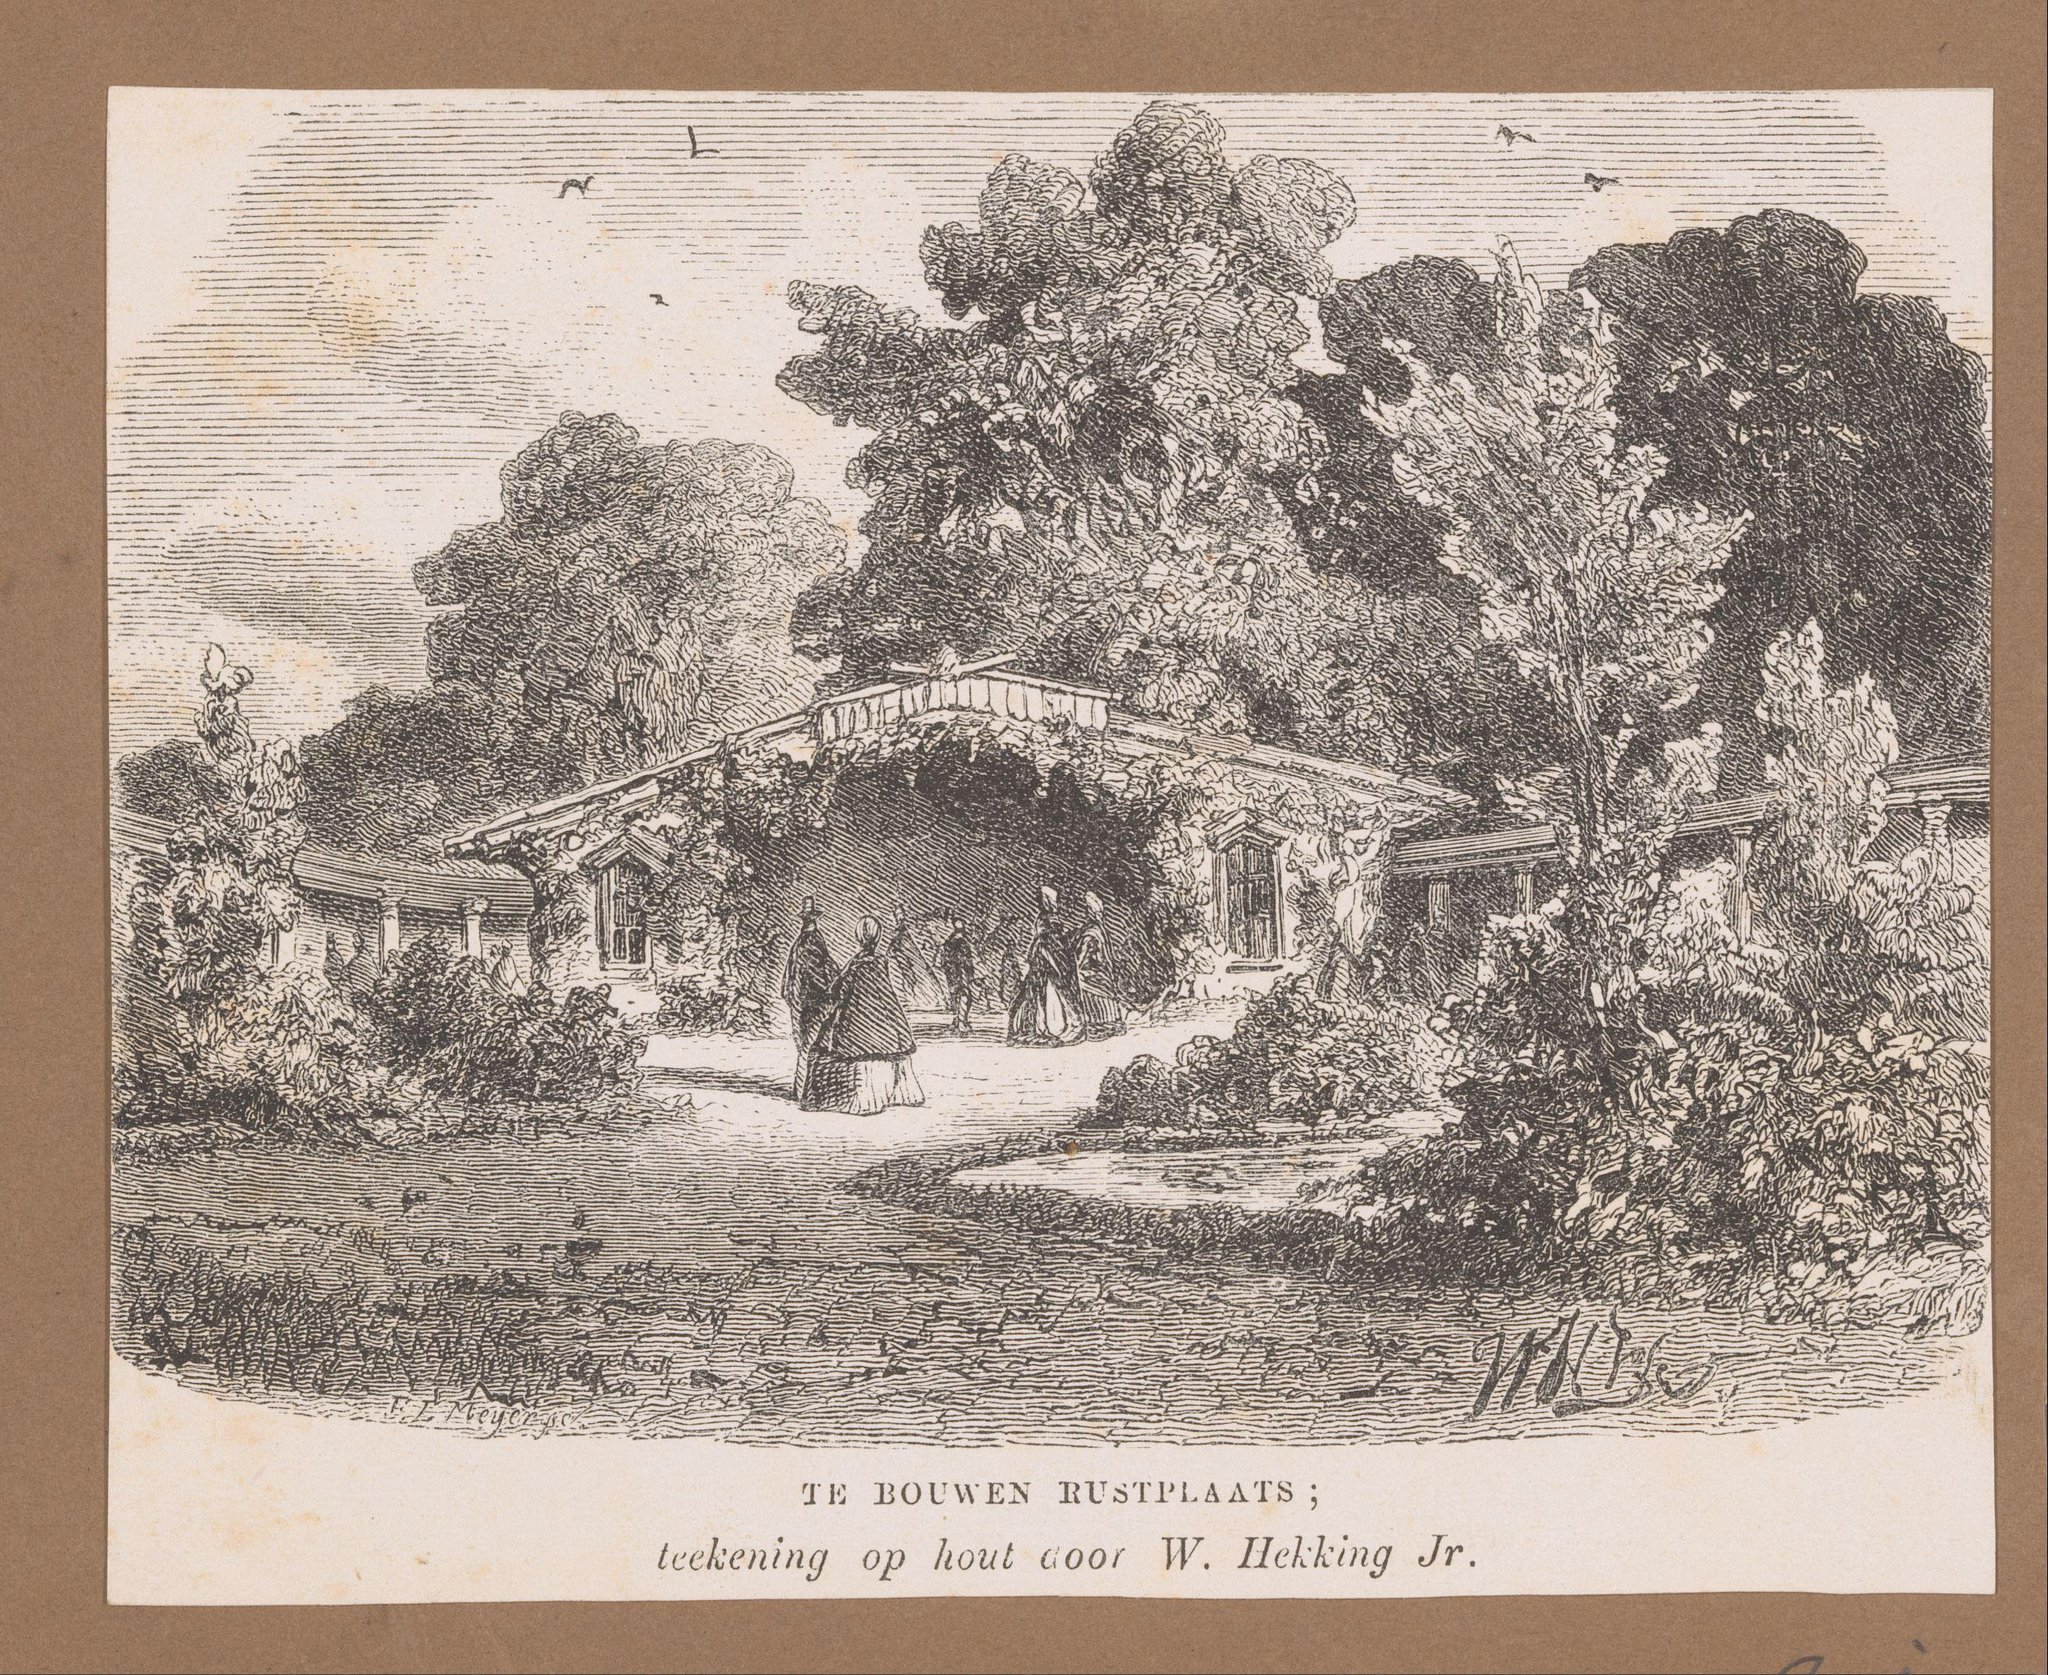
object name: book illustration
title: Te bouwen rustplaats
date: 1866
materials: paper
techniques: letterpress printing, engraving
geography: amsterdam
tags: park, hut, cabin, lodge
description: Prent uit: Witkamp, P.H. 'Het Rij en Wandelpark te Amsterdam', Het Nederlandsch Magazijn (1866), nr. 10, p. 77.